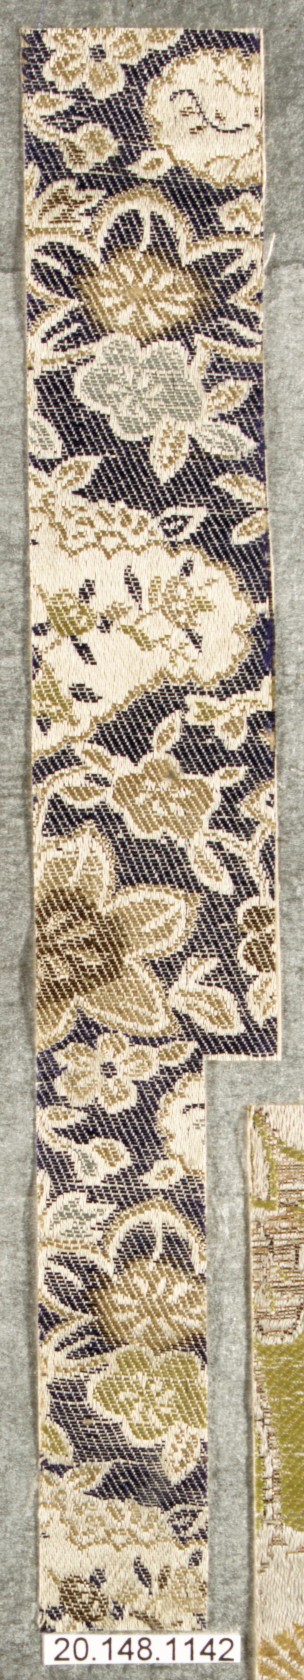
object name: piece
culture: japanese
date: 1801-1900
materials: silk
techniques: compound weave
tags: flowers